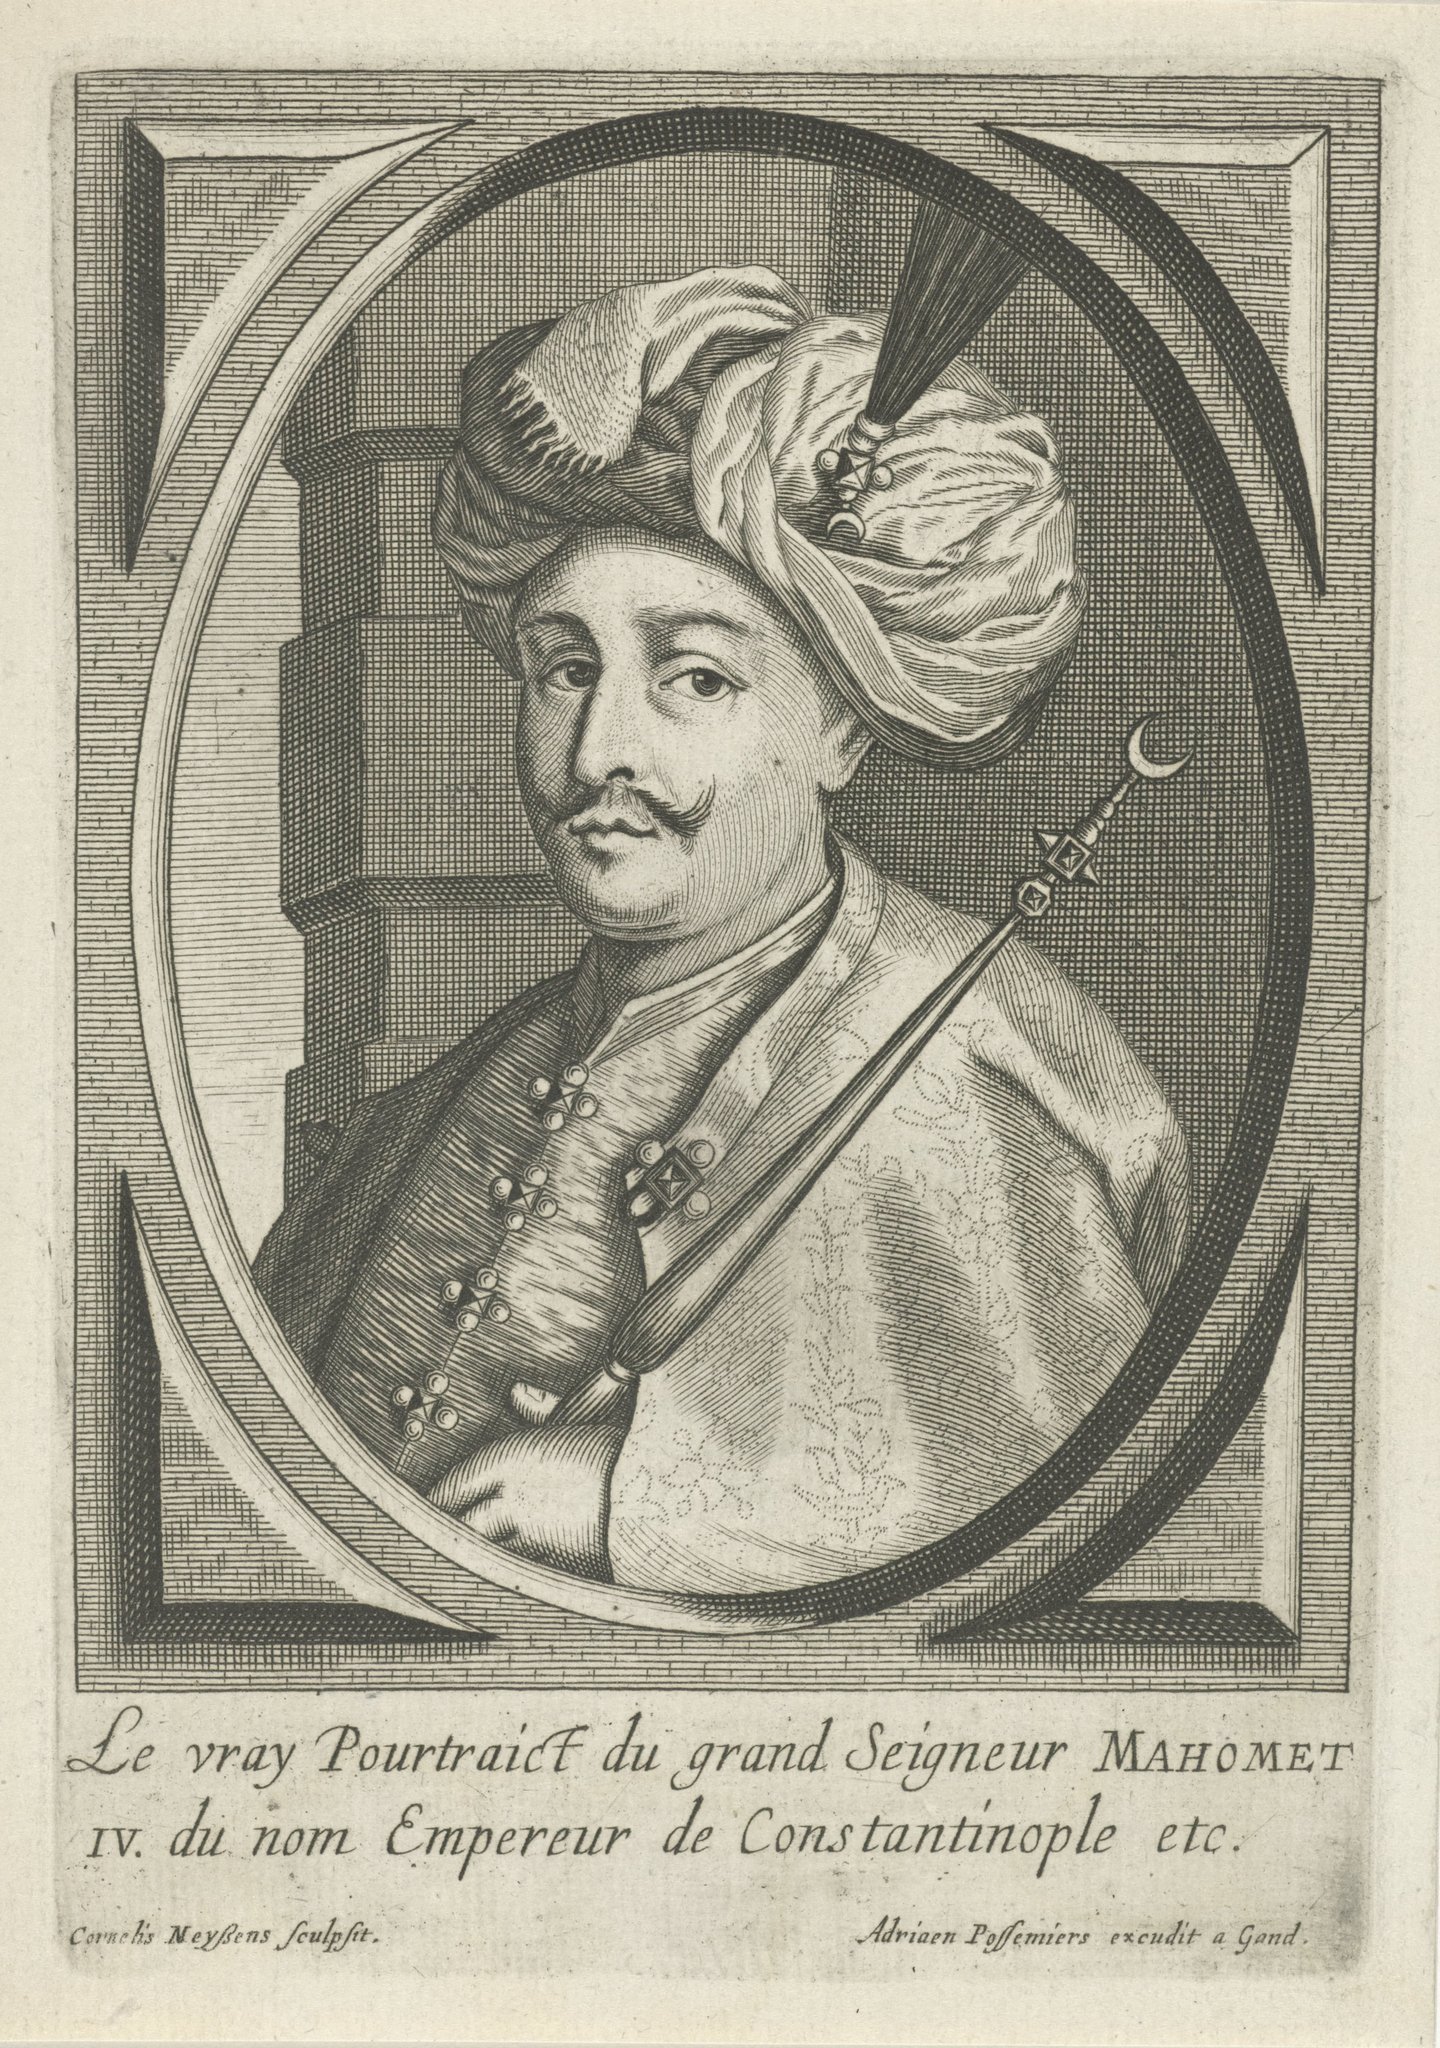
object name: print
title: Portret van sultan Mehmet IV van het Ottomaanse Rijk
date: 1650-1693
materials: paper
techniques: engraving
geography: ghent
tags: constantinopel, mehmet iv (sultan van het ottomaanse rijk)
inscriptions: collector's mark: Lugt 2228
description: Portret van Mehmet IV, sultan van het Ottomaanse Rijk, met een scepter in zijn hand. Volgens het Franse onderschrift onderaan in de marge het echte portret.